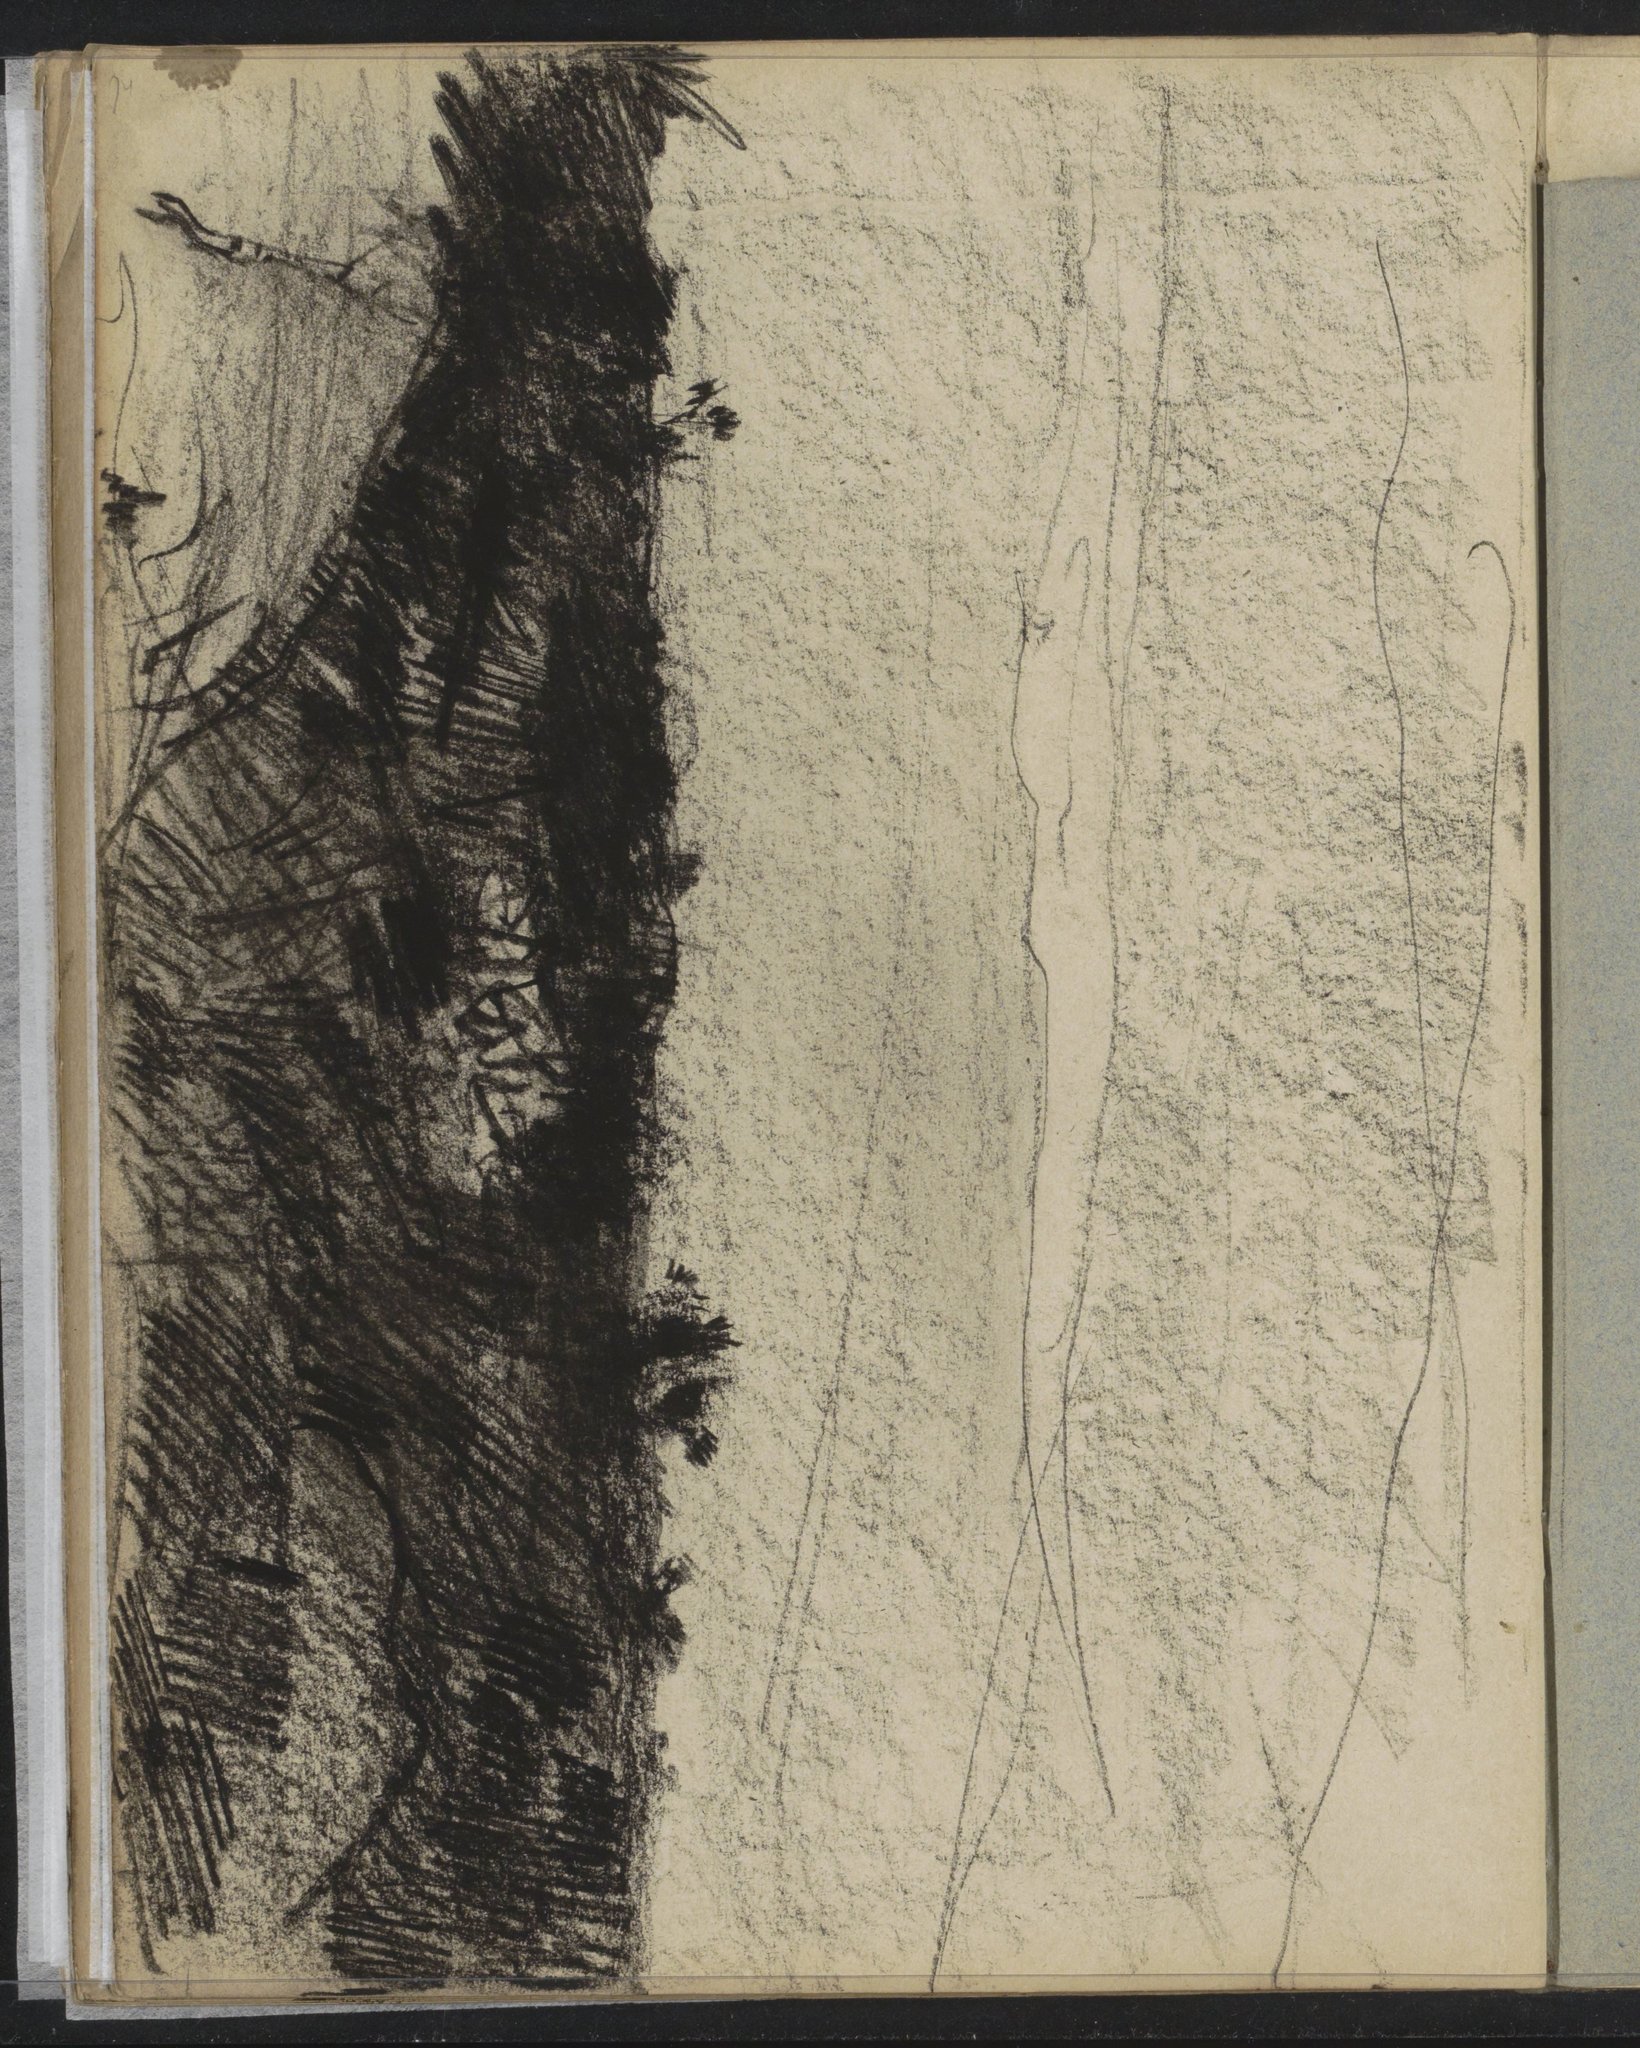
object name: sketchbook leaf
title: Landschap met vegetatie, mogelijk heide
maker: willem witsen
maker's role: draughtsman, painter, print maker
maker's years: 1860-1923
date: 1886-1891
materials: chalk, paper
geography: ede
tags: landscapes in the temperate zone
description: Pagina 74 uit een schetsboek met 40 bladen.